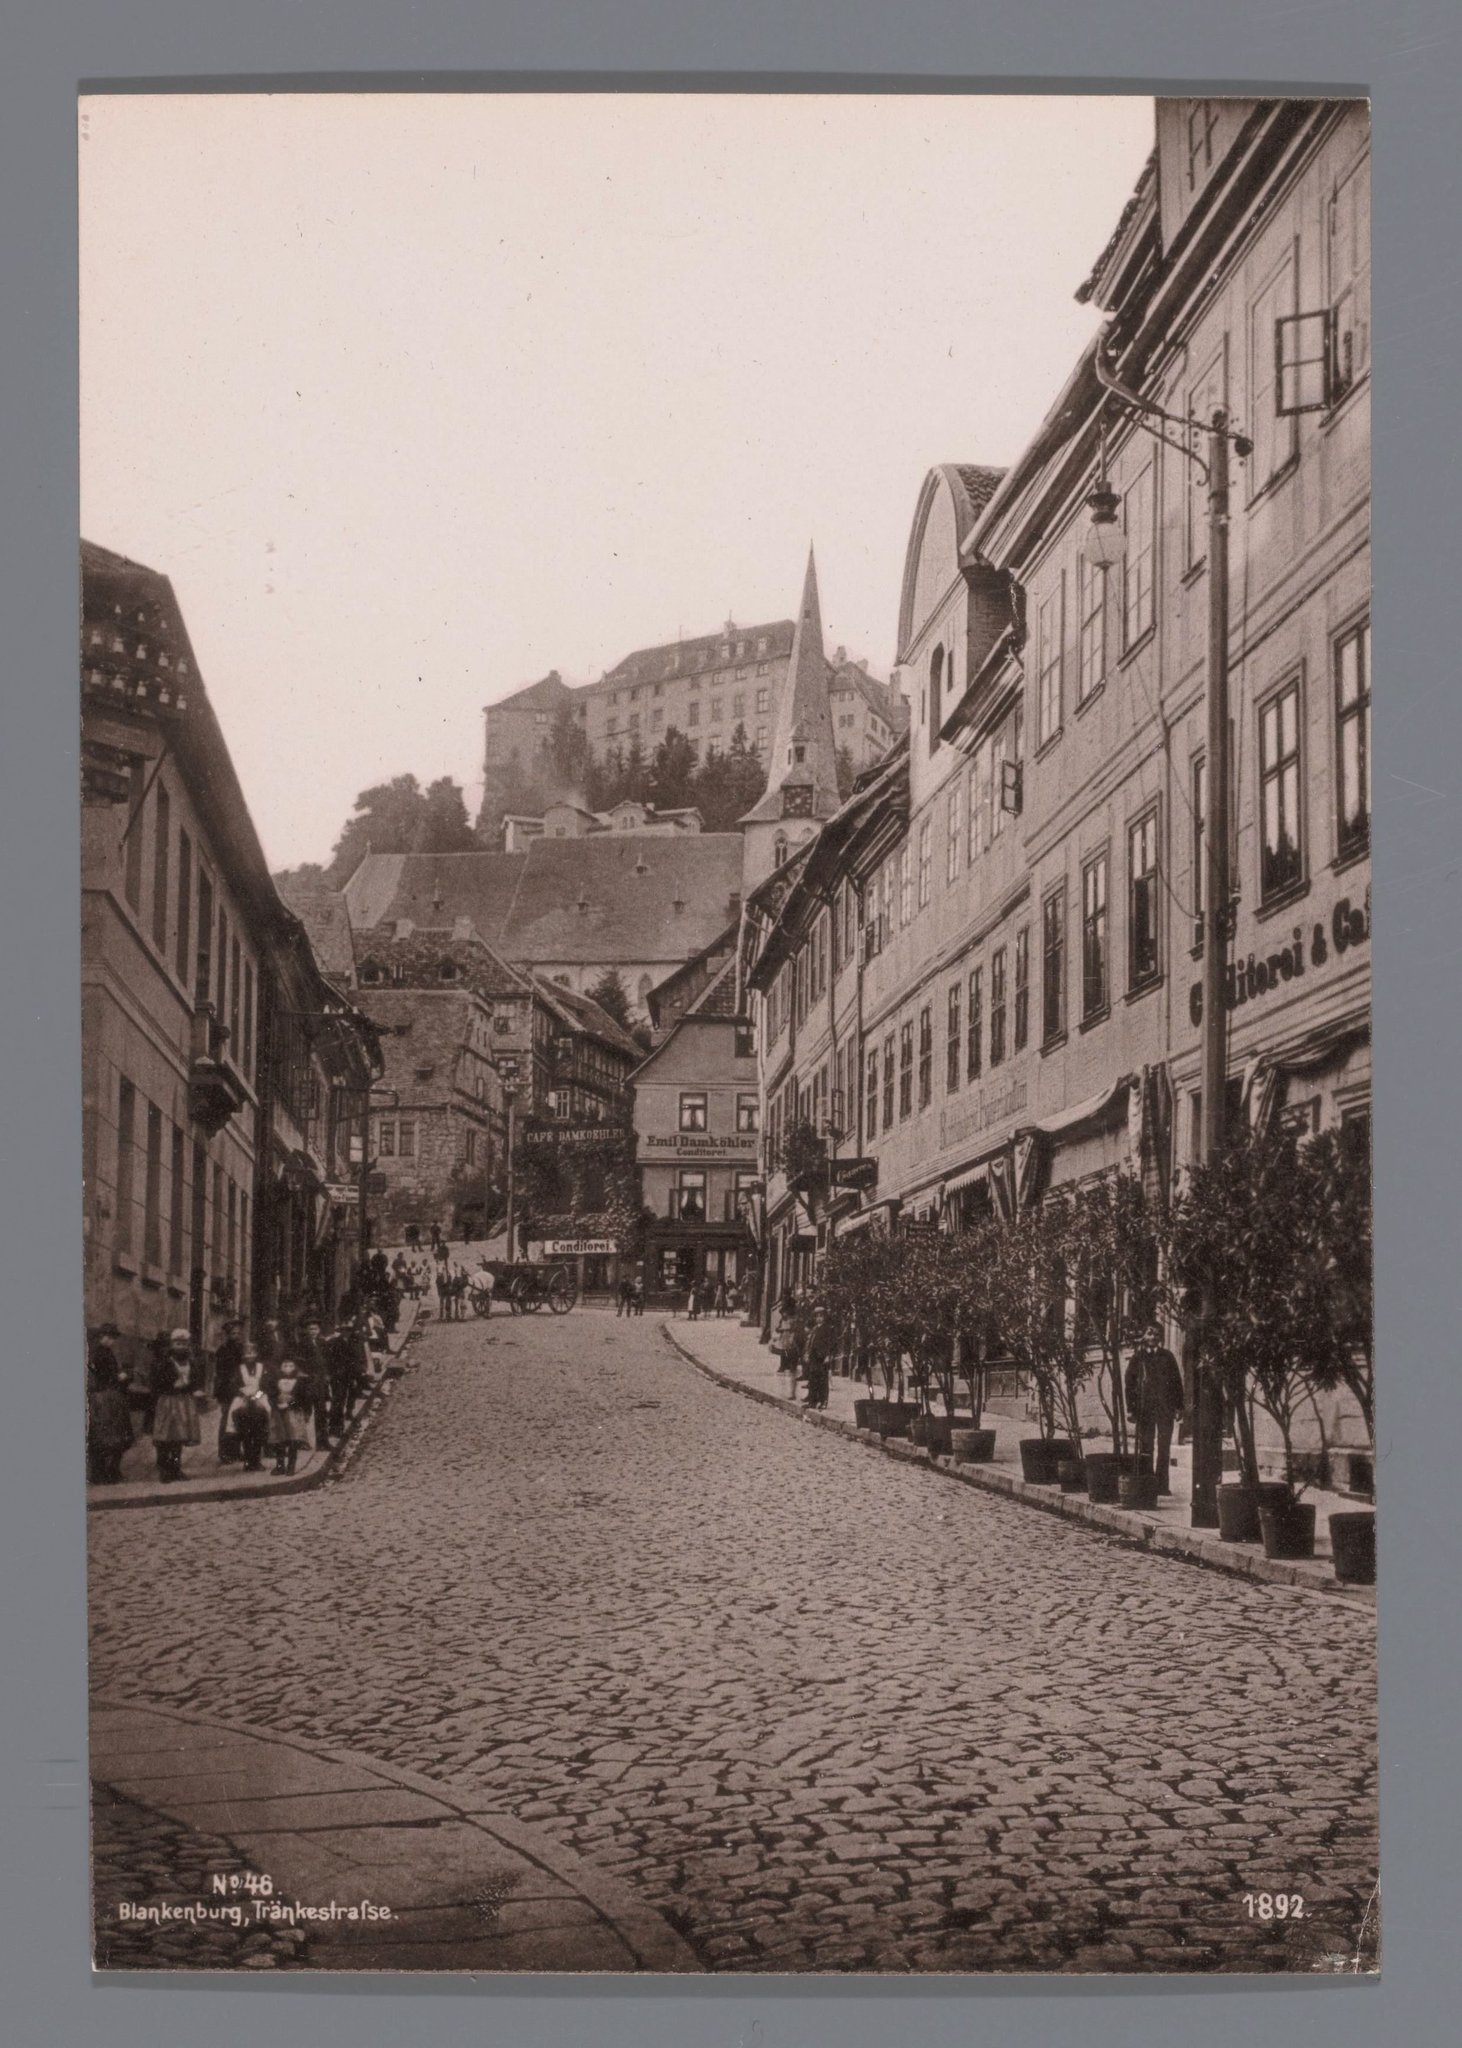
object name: photomechanical print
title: Blankenburg, Tränkestrasse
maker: Anonymous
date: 1892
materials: paper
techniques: photograph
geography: blankenburg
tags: street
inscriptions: inscription: ‘No 46./ Blankenburg, Tränkestrasse./ 1892.’